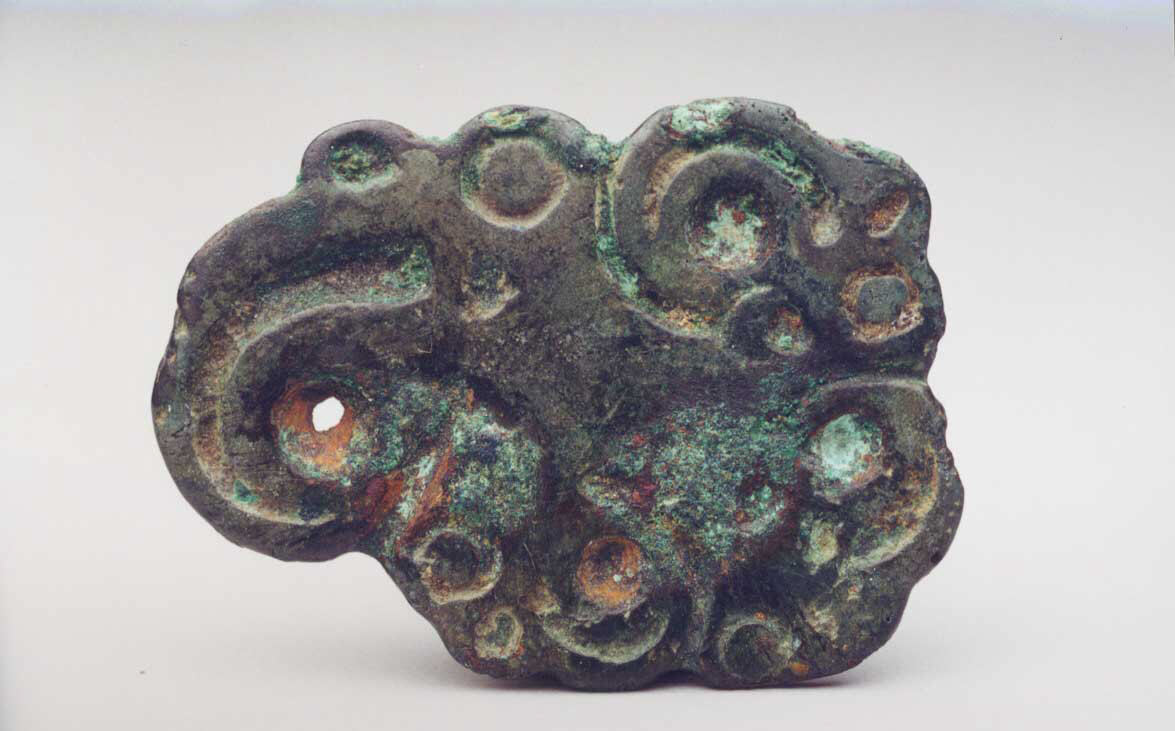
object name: garment plaque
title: Garment Plaque with Raptor's Heads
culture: chinese or mongolian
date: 600-401 BCE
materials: bronze